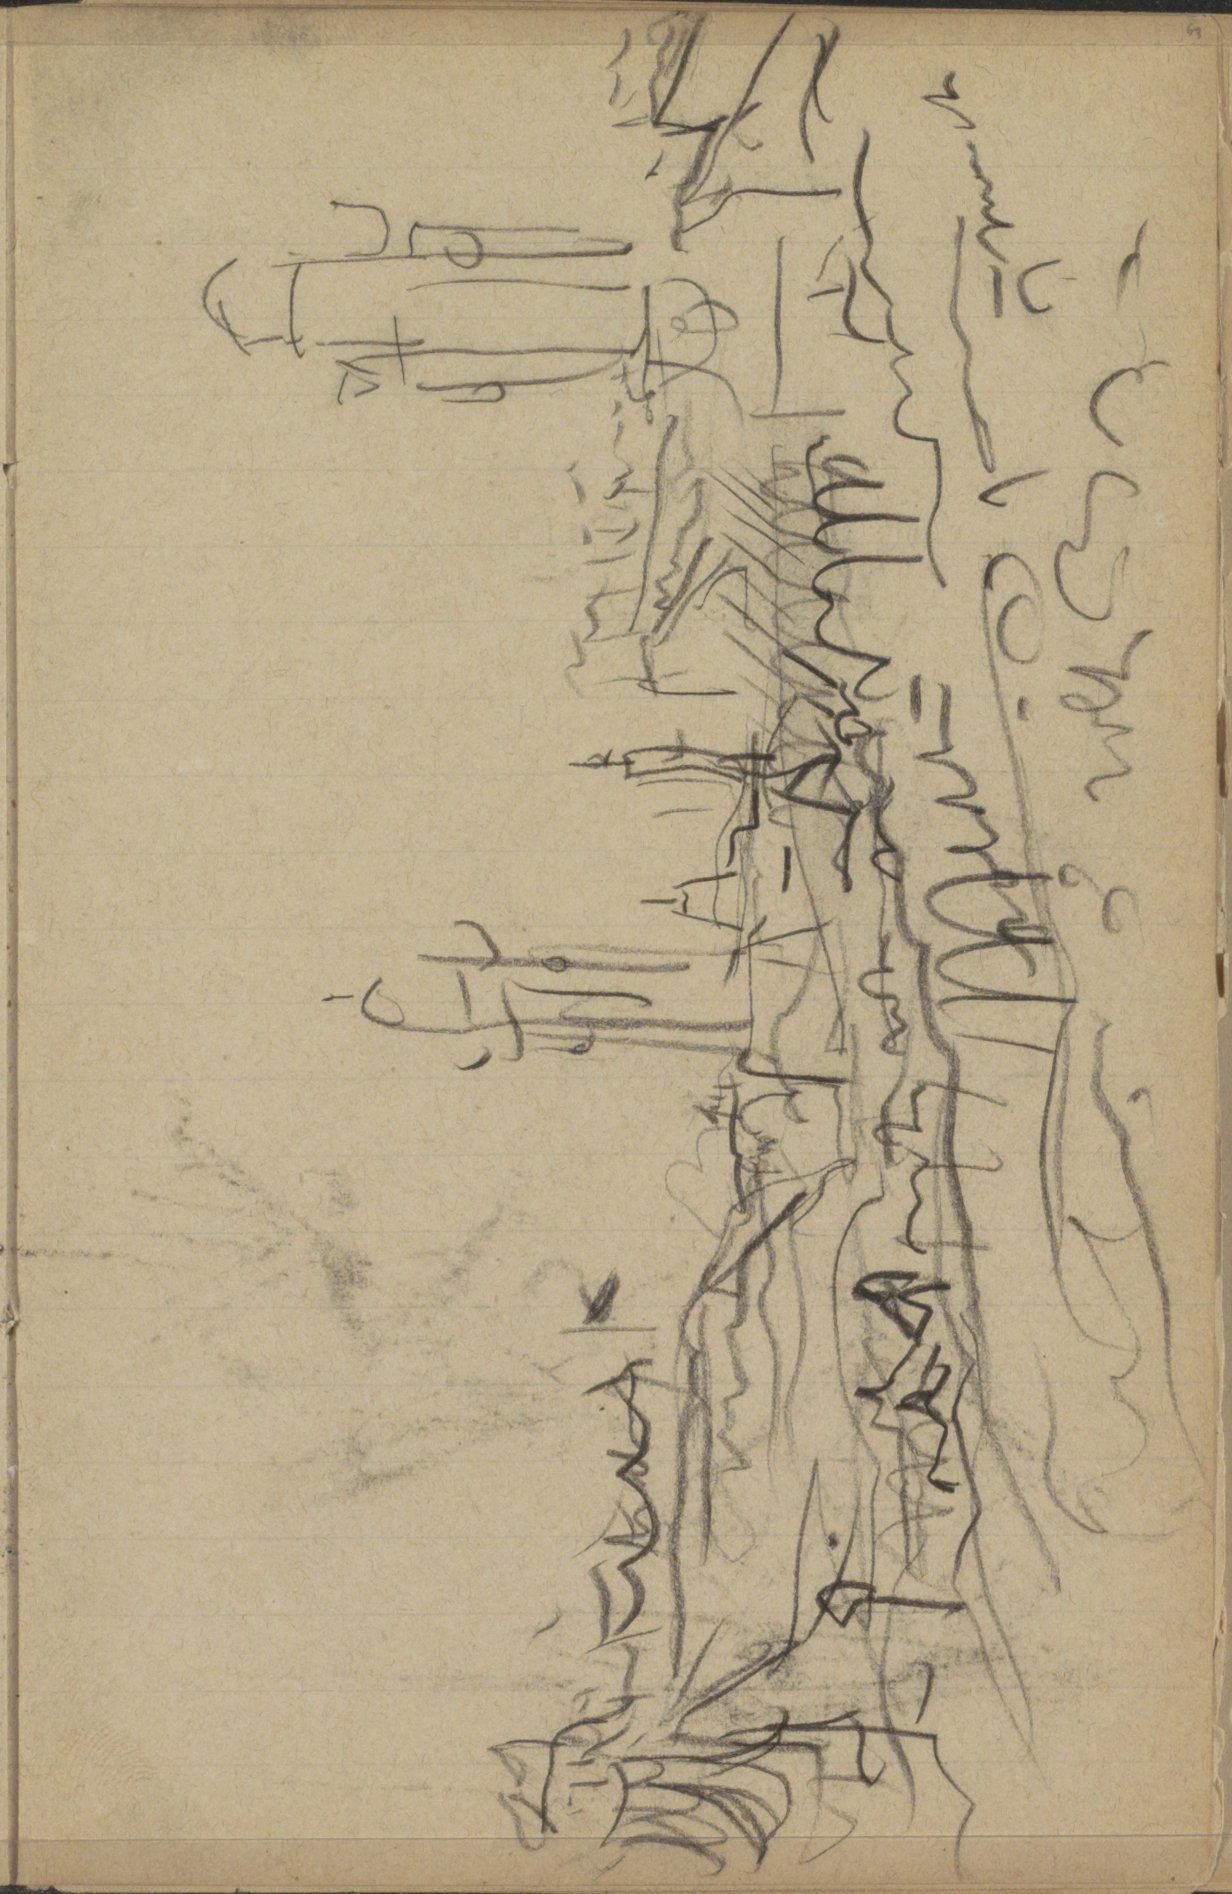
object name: sketchbook leaf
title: Gezicht op een stad, vermoedelijk Moskou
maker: marius bauer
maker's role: draughtsman, print maker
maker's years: 1867-1932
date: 1896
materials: chalk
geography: moscow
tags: city-view, and landscape with man-made constructions, tower (of house or building)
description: Pagina 63 uit een schetsboek met 50 bladen.